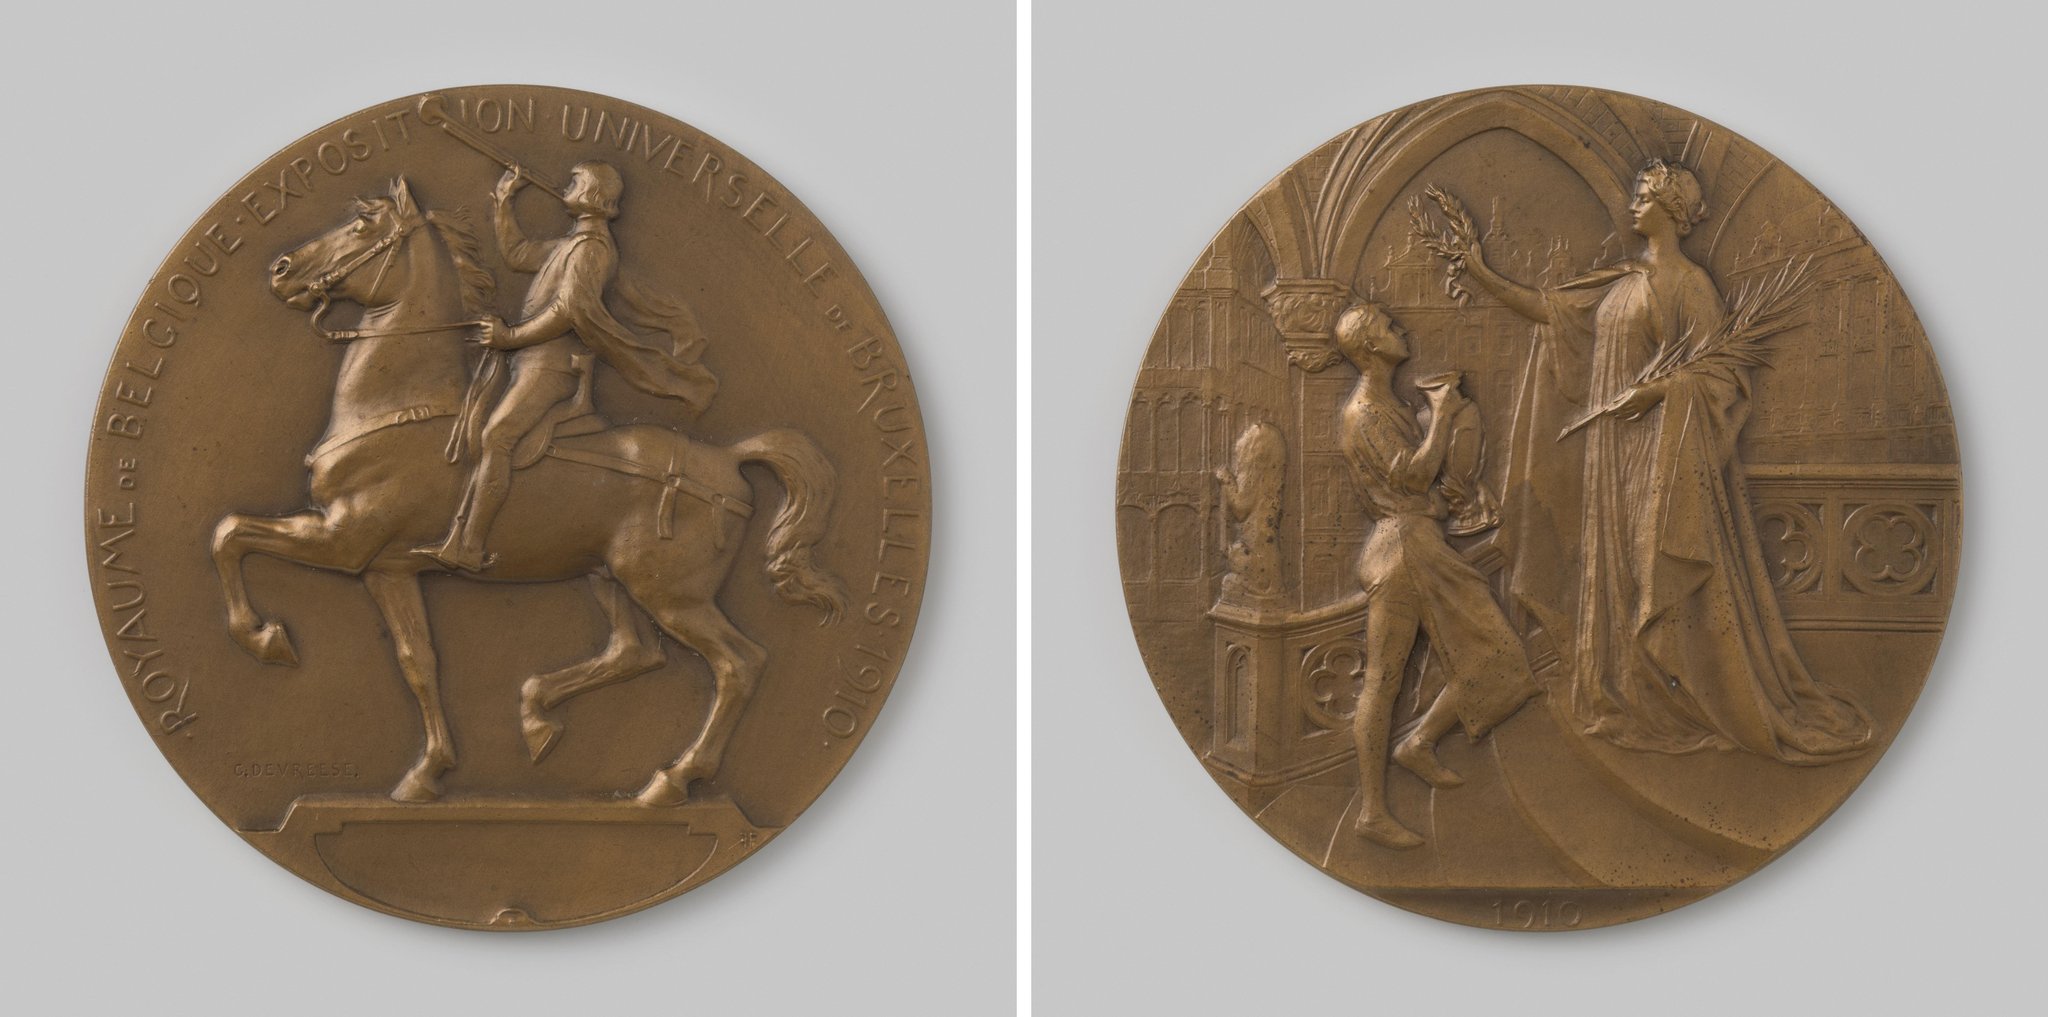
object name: history medal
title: Wereldtentoonstelling te Brussel 1910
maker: godefroid devreese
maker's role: sculptor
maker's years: 1861-1941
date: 1910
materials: bronze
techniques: striking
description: Bronzen penning, op de voorzijde een heraut met trompet te paard naar links, met omschrift, op de keerzijde monumentale trap waarop een vrouw met palmtak een arbeider met voorschoot lauwert die haar een vaas brengt, met afsnedetekst.